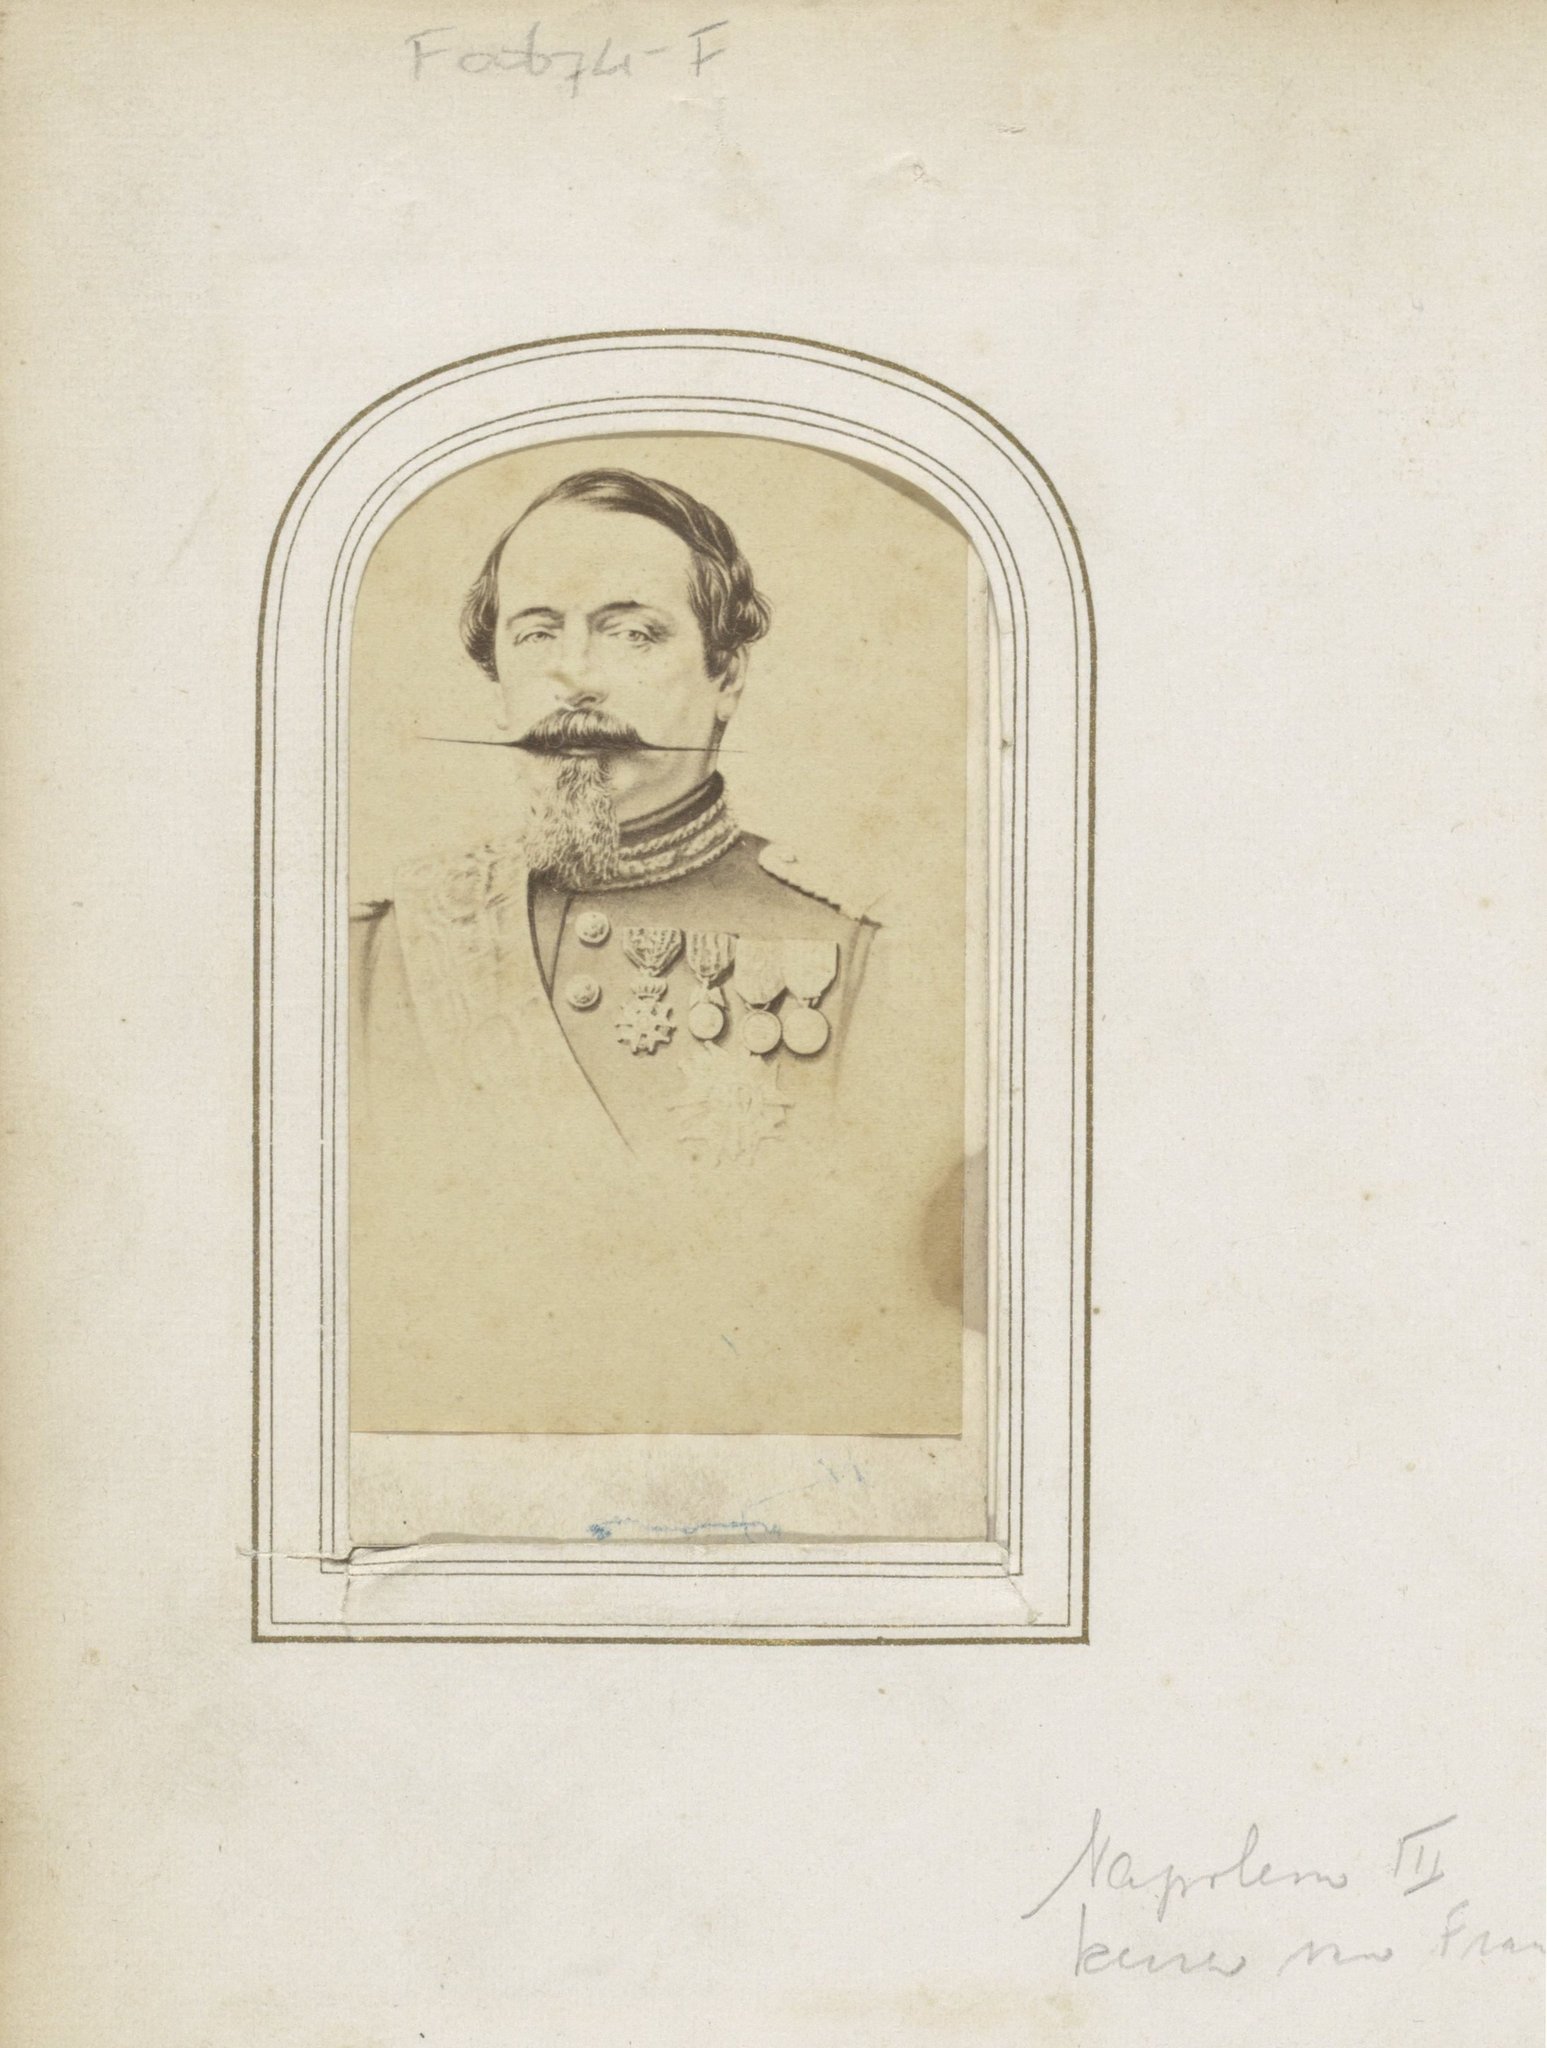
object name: carte de visite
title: Portret van Napoleon III Bonaparte, keizer van Frankrijk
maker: Anonymous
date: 1855-1871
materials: cardboard, paper, photographic support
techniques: albumen print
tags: paris, london, napoleon iii (keizer der fransen), moustache, medals and other marks of military honour, ruler, sovereign, decorations, honours (as symbols of the state, etc.), (military) uniforms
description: Onderdeel van Fotoalbum met 123 cartes-de-visite van leden van Europese vorstenhuizen, politici en bekende personen.